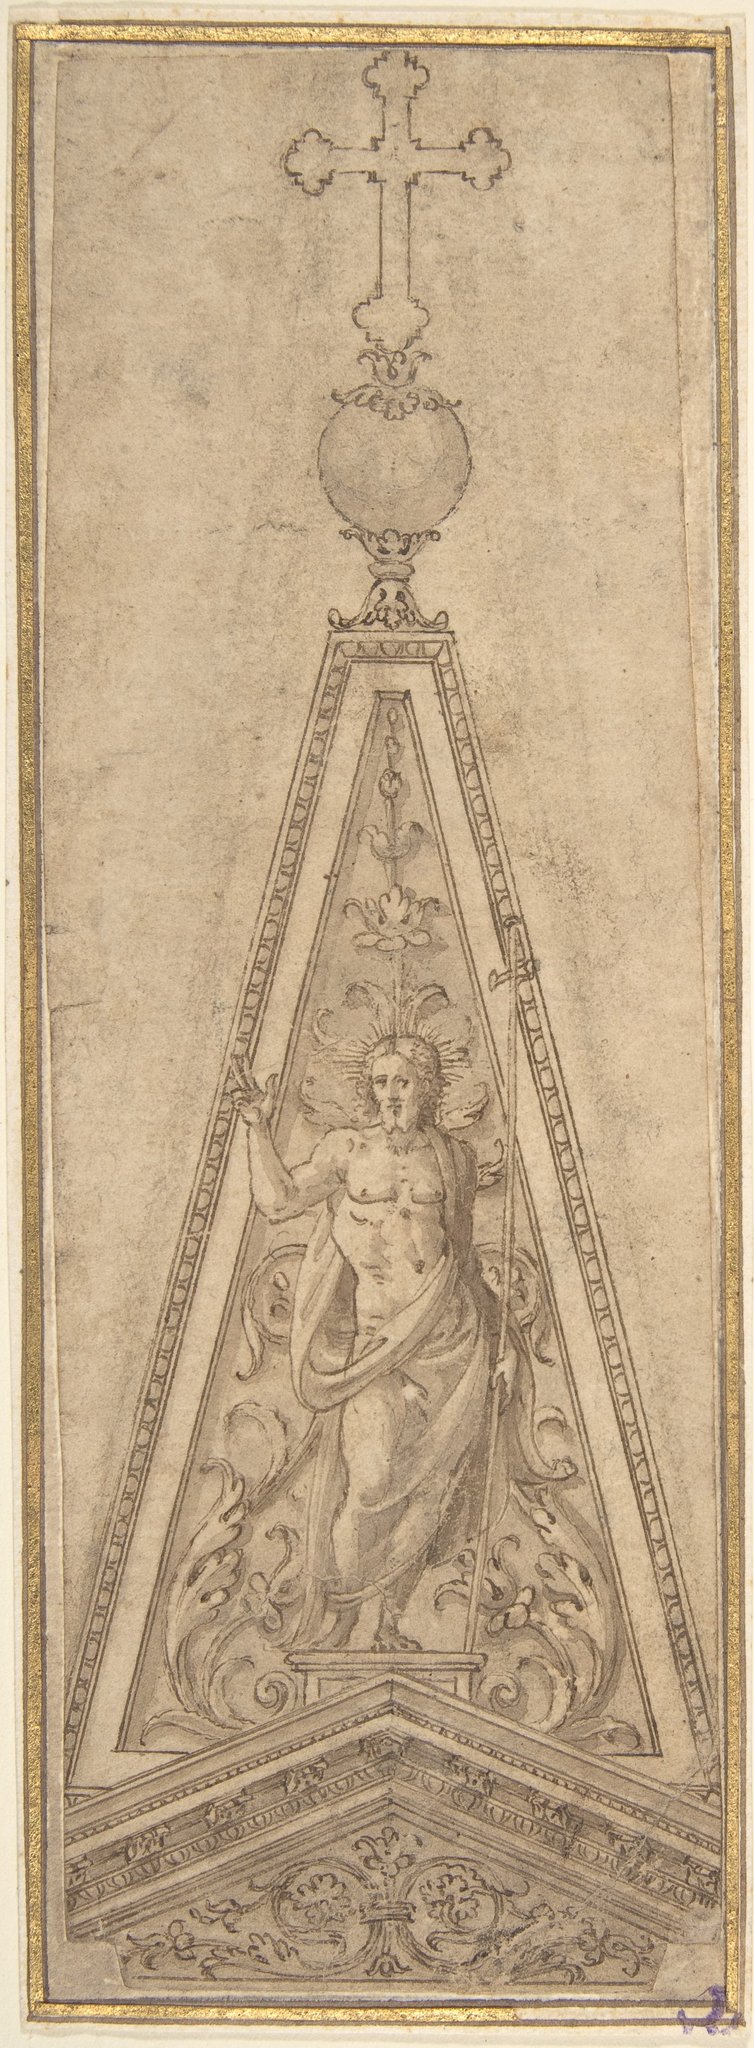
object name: drawing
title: Design for Pediments with the Resurrected Christ surmounted by a Crucifix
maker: anonymous, italian, 16th century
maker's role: artist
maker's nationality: italian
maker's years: 1500-1600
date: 1501-1600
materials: ink, drawing material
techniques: brush, pen, wash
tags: christ